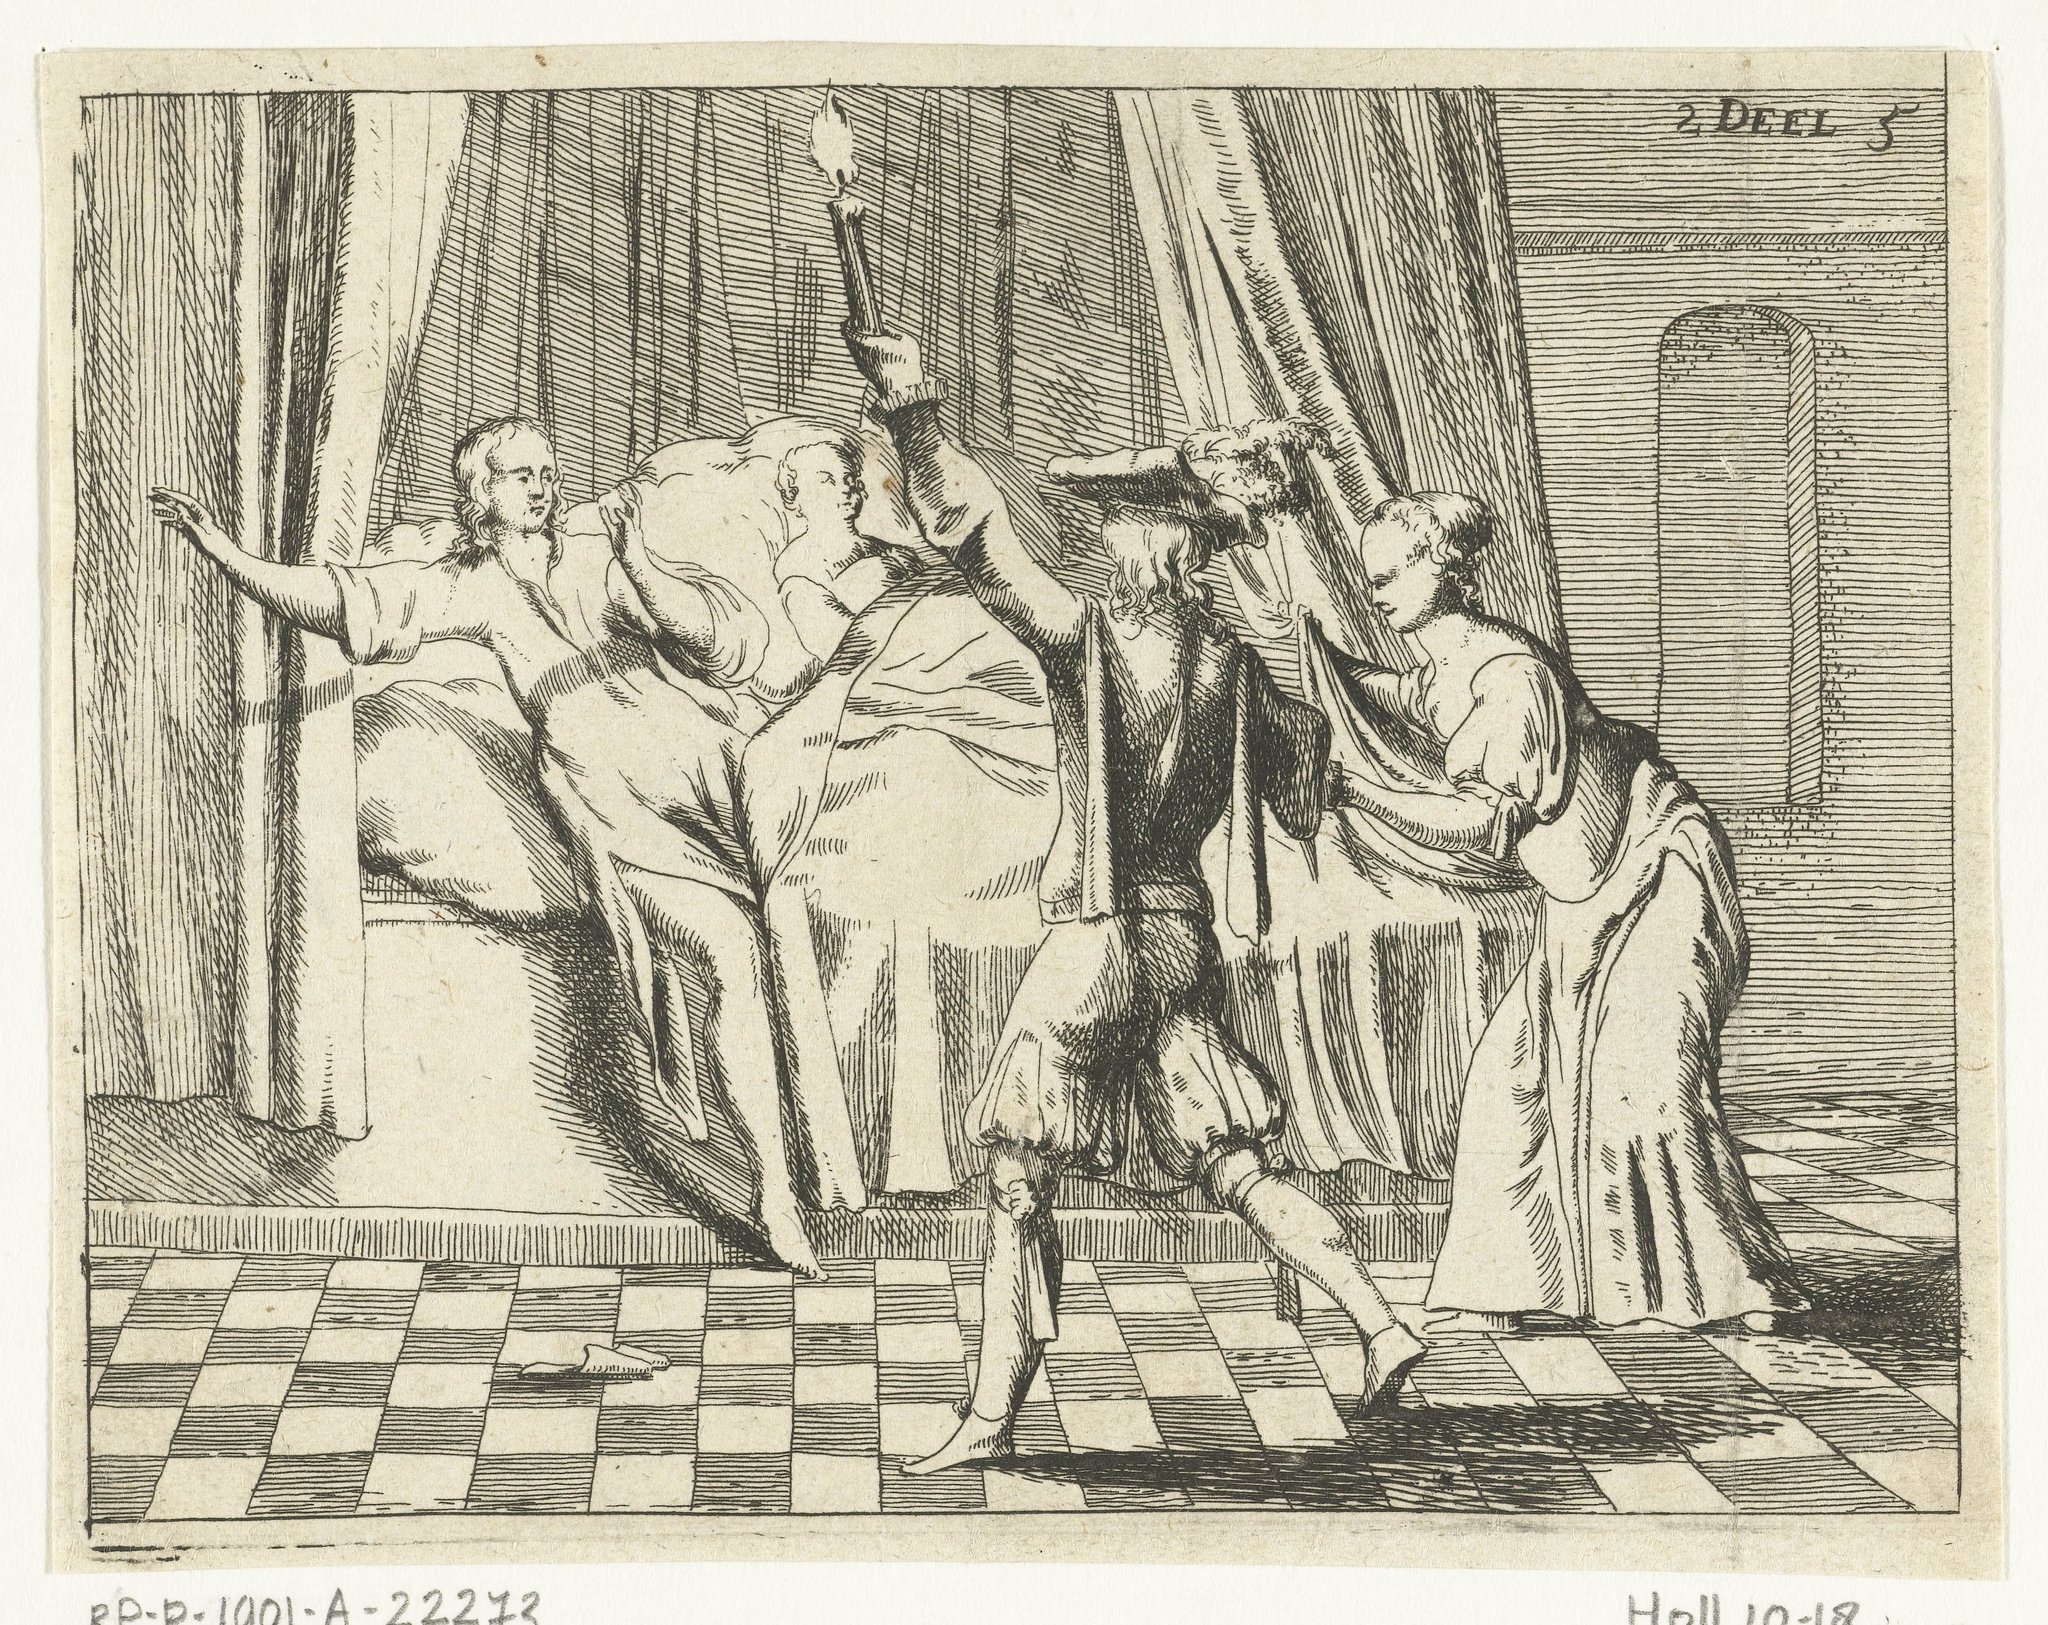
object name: print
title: Gusman d'Alfarache bij bed met dames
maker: jan de bray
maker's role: draughtsman, print maker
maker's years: 1627-1697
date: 1655-1697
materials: paper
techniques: etching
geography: netherlands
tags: bedroom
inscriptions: collector's mark: Lugt 2228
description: Boekillustratie uit: Mateo Alemán, Het leven van Gusman d'Alfarache, mogelijk Rotterdam, onbekend jaar, deel 2, nr. 5, Alvin 1311-1318